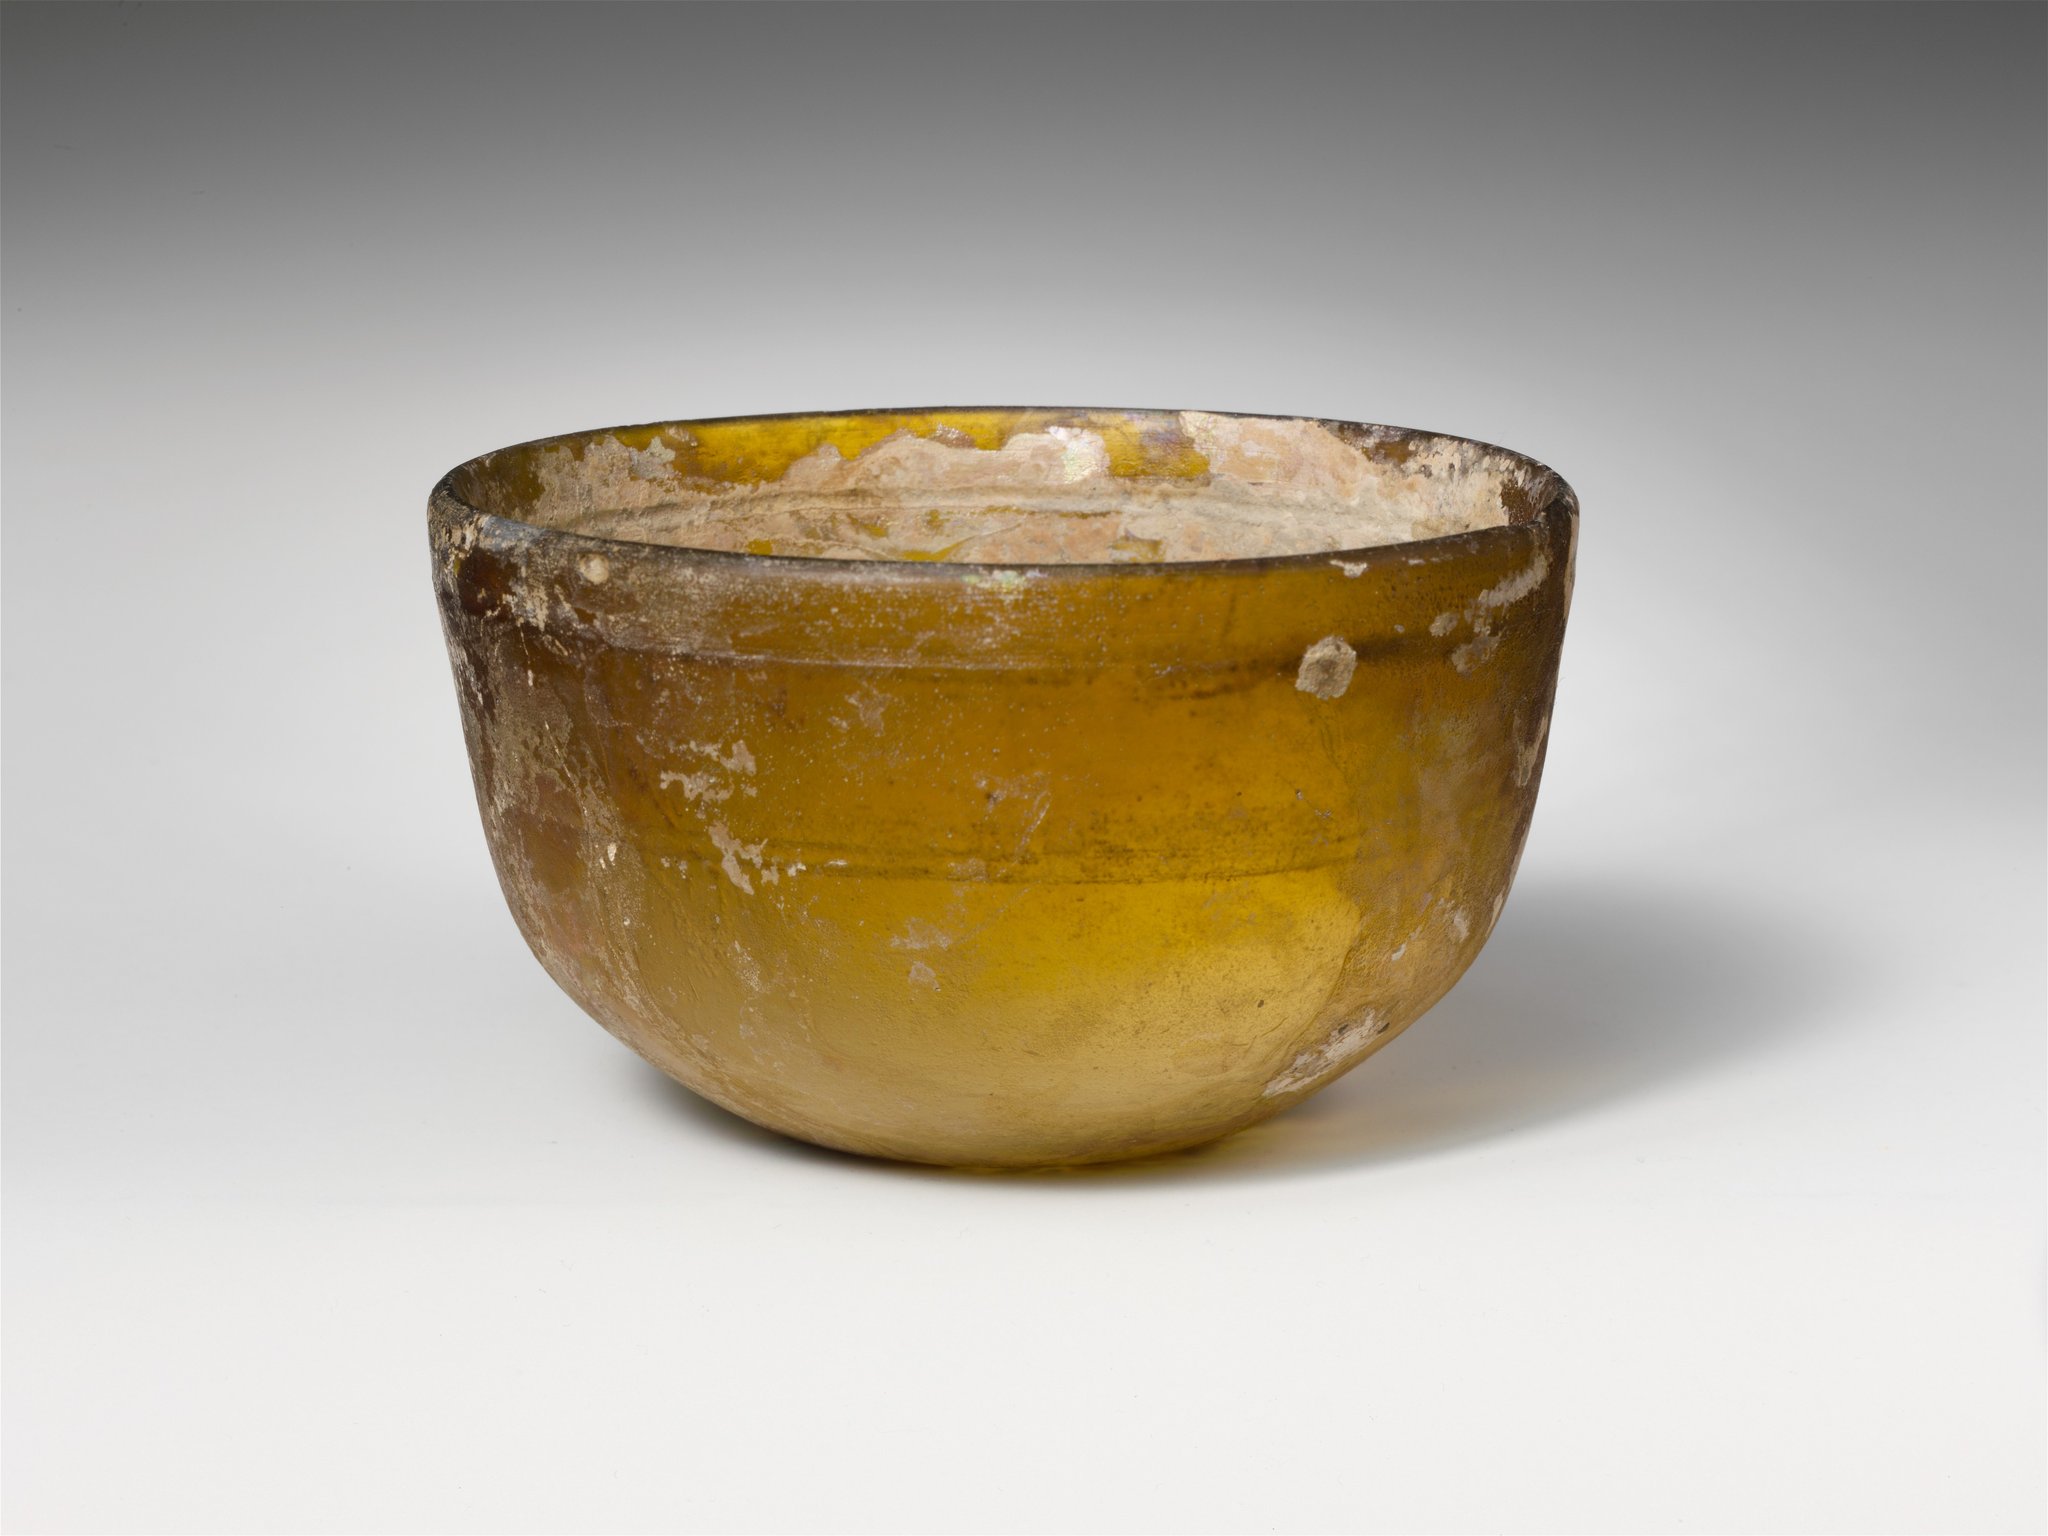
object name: bowl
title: Glass bowl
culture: roman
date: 34 BCE-33 CE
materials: glass